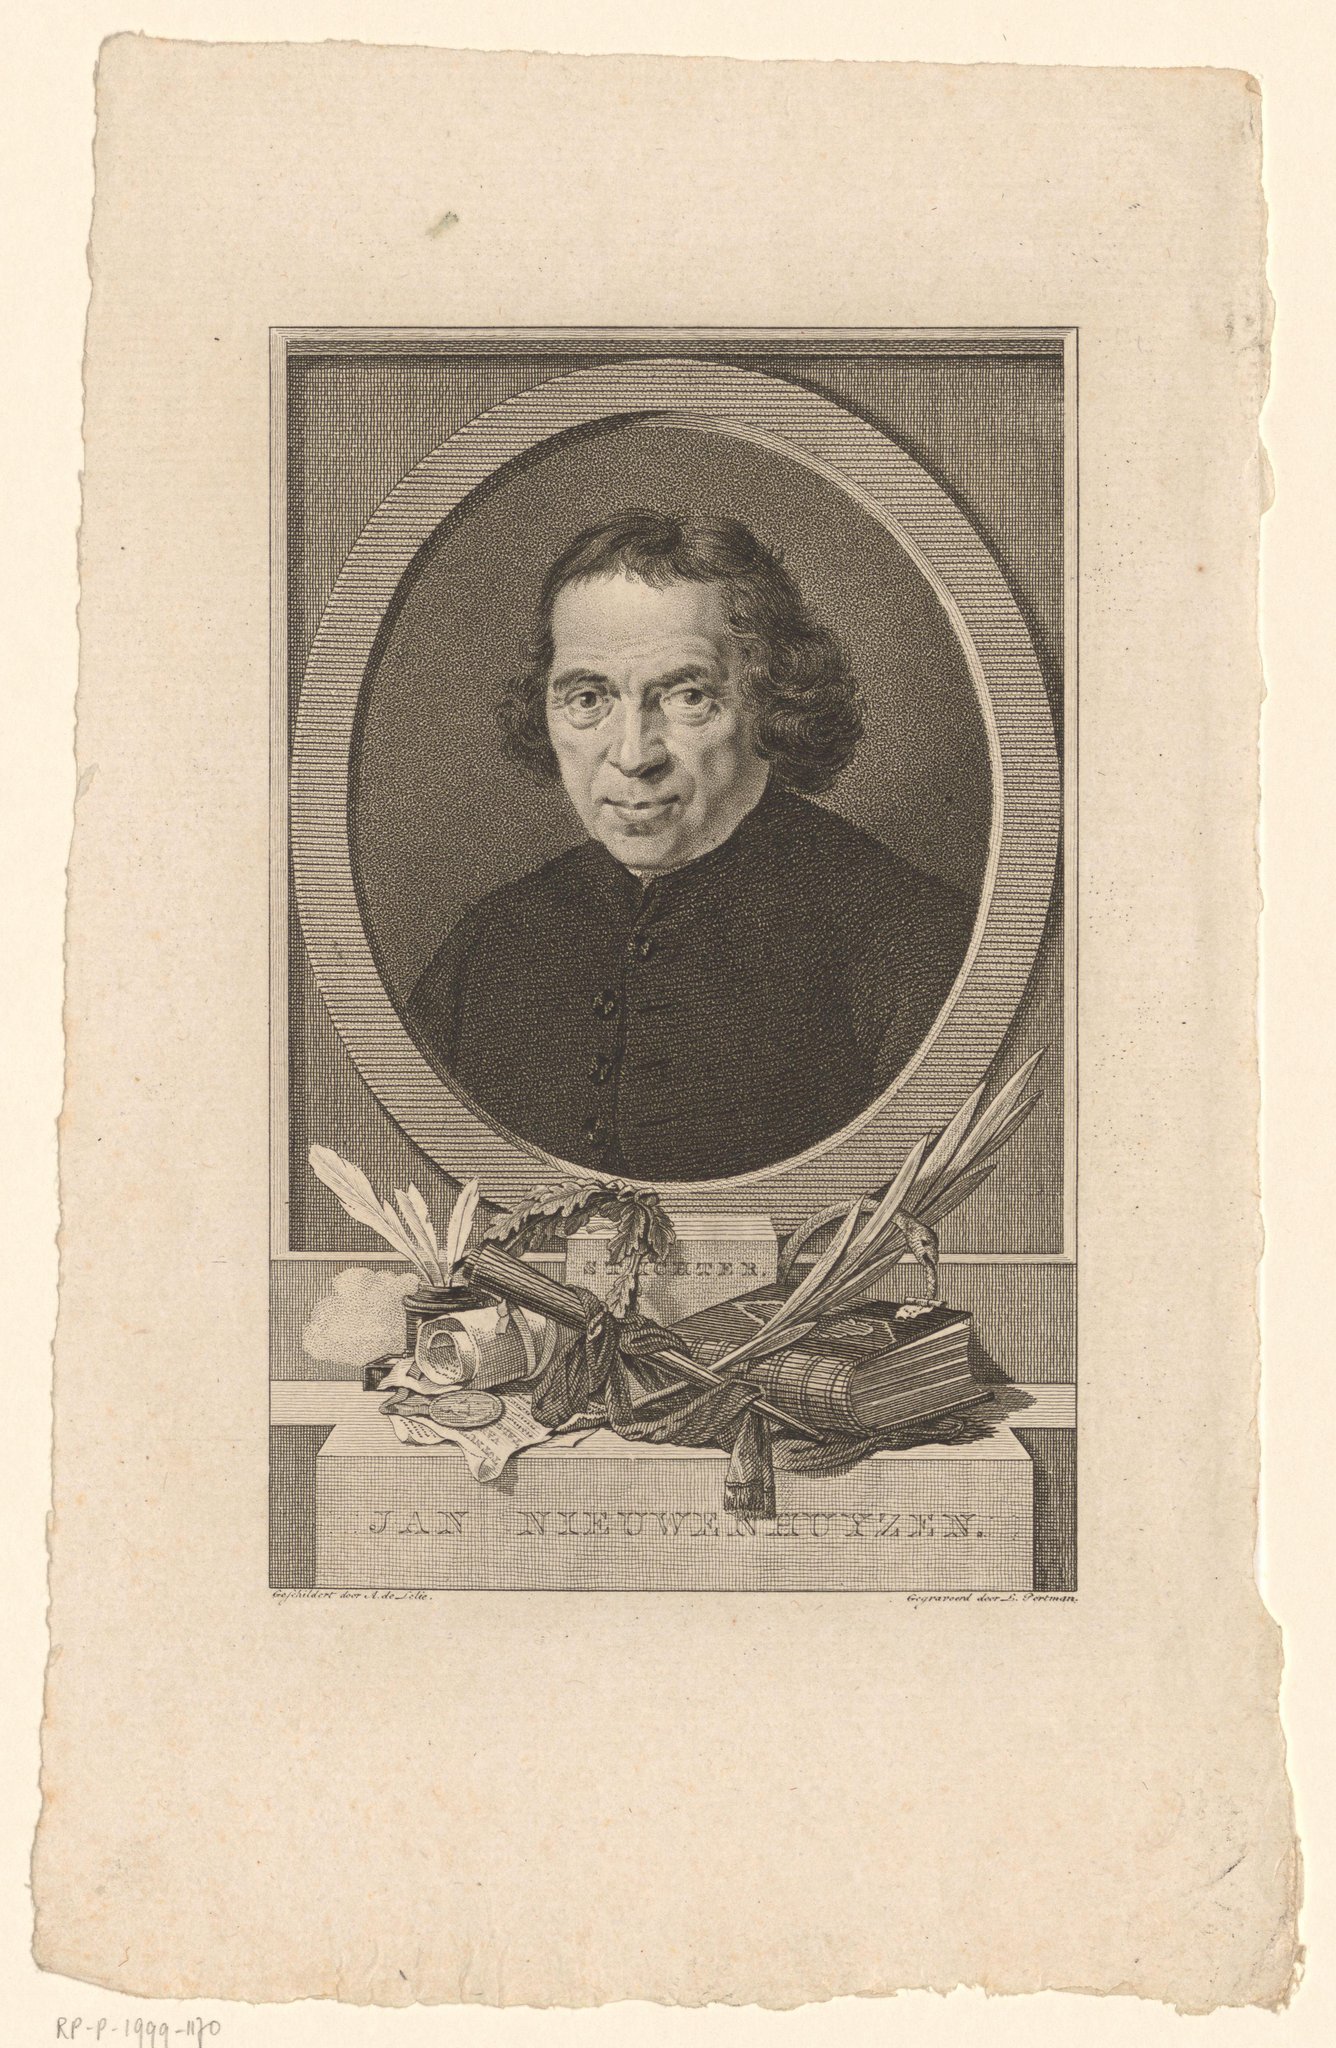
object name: print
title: Portret van Jan Nieuwenhuyzen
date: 1787-1828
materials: paper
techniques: engraving, etching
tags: haarlem, jan nieuwenhuyzen, historical persons, functionaries and dignitaries ~ protestant churches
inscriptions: collector's mark: Lugt 2228, collector's mark: Lugt 2760